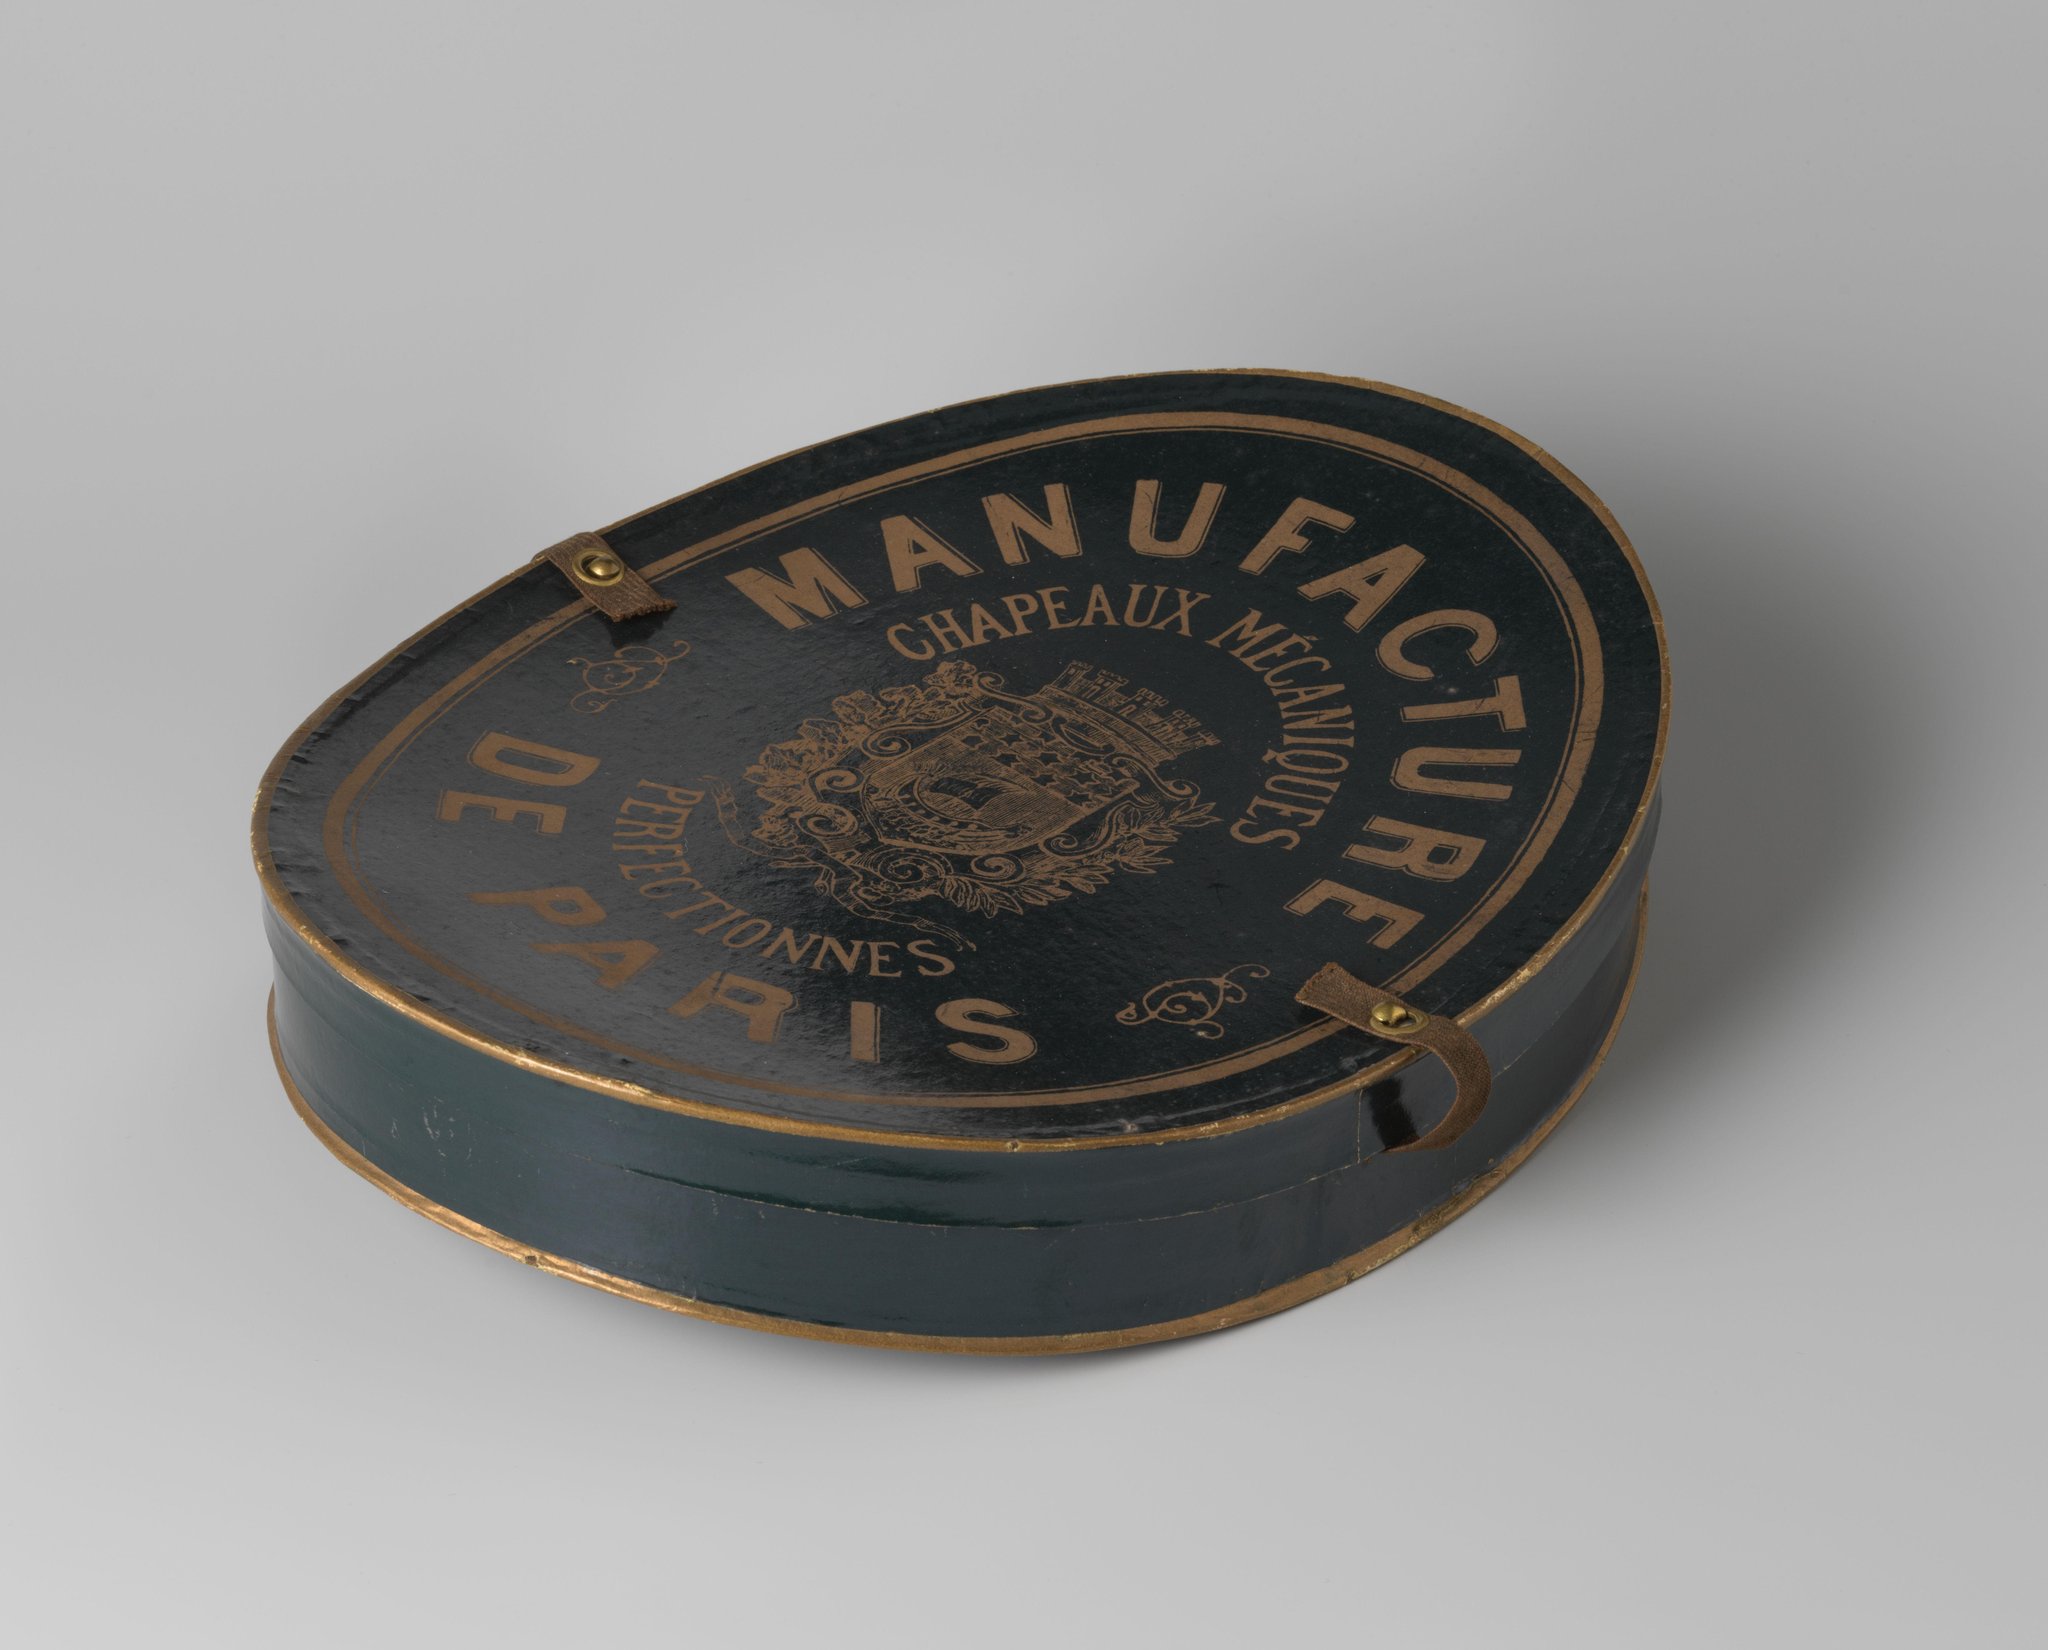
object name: verpakking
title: Hoedendoos, met groen papier beplakt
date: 1900-1950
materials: cardboard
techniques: pasting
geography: paris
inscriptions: factory mark: ‘MANUFACTURE // DE PARIS // CHAPEAUX MECANIQUES // PERFECTIONNES; in het midden het wapen van Parijs’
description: Hoedendoos, plat model, met groen papier beplakt. Op de doos: MANUFACTURE // DE PARIS // CHAPEAUX MECANIQUES // PERFECTIONNES en het wapen van Parijs.